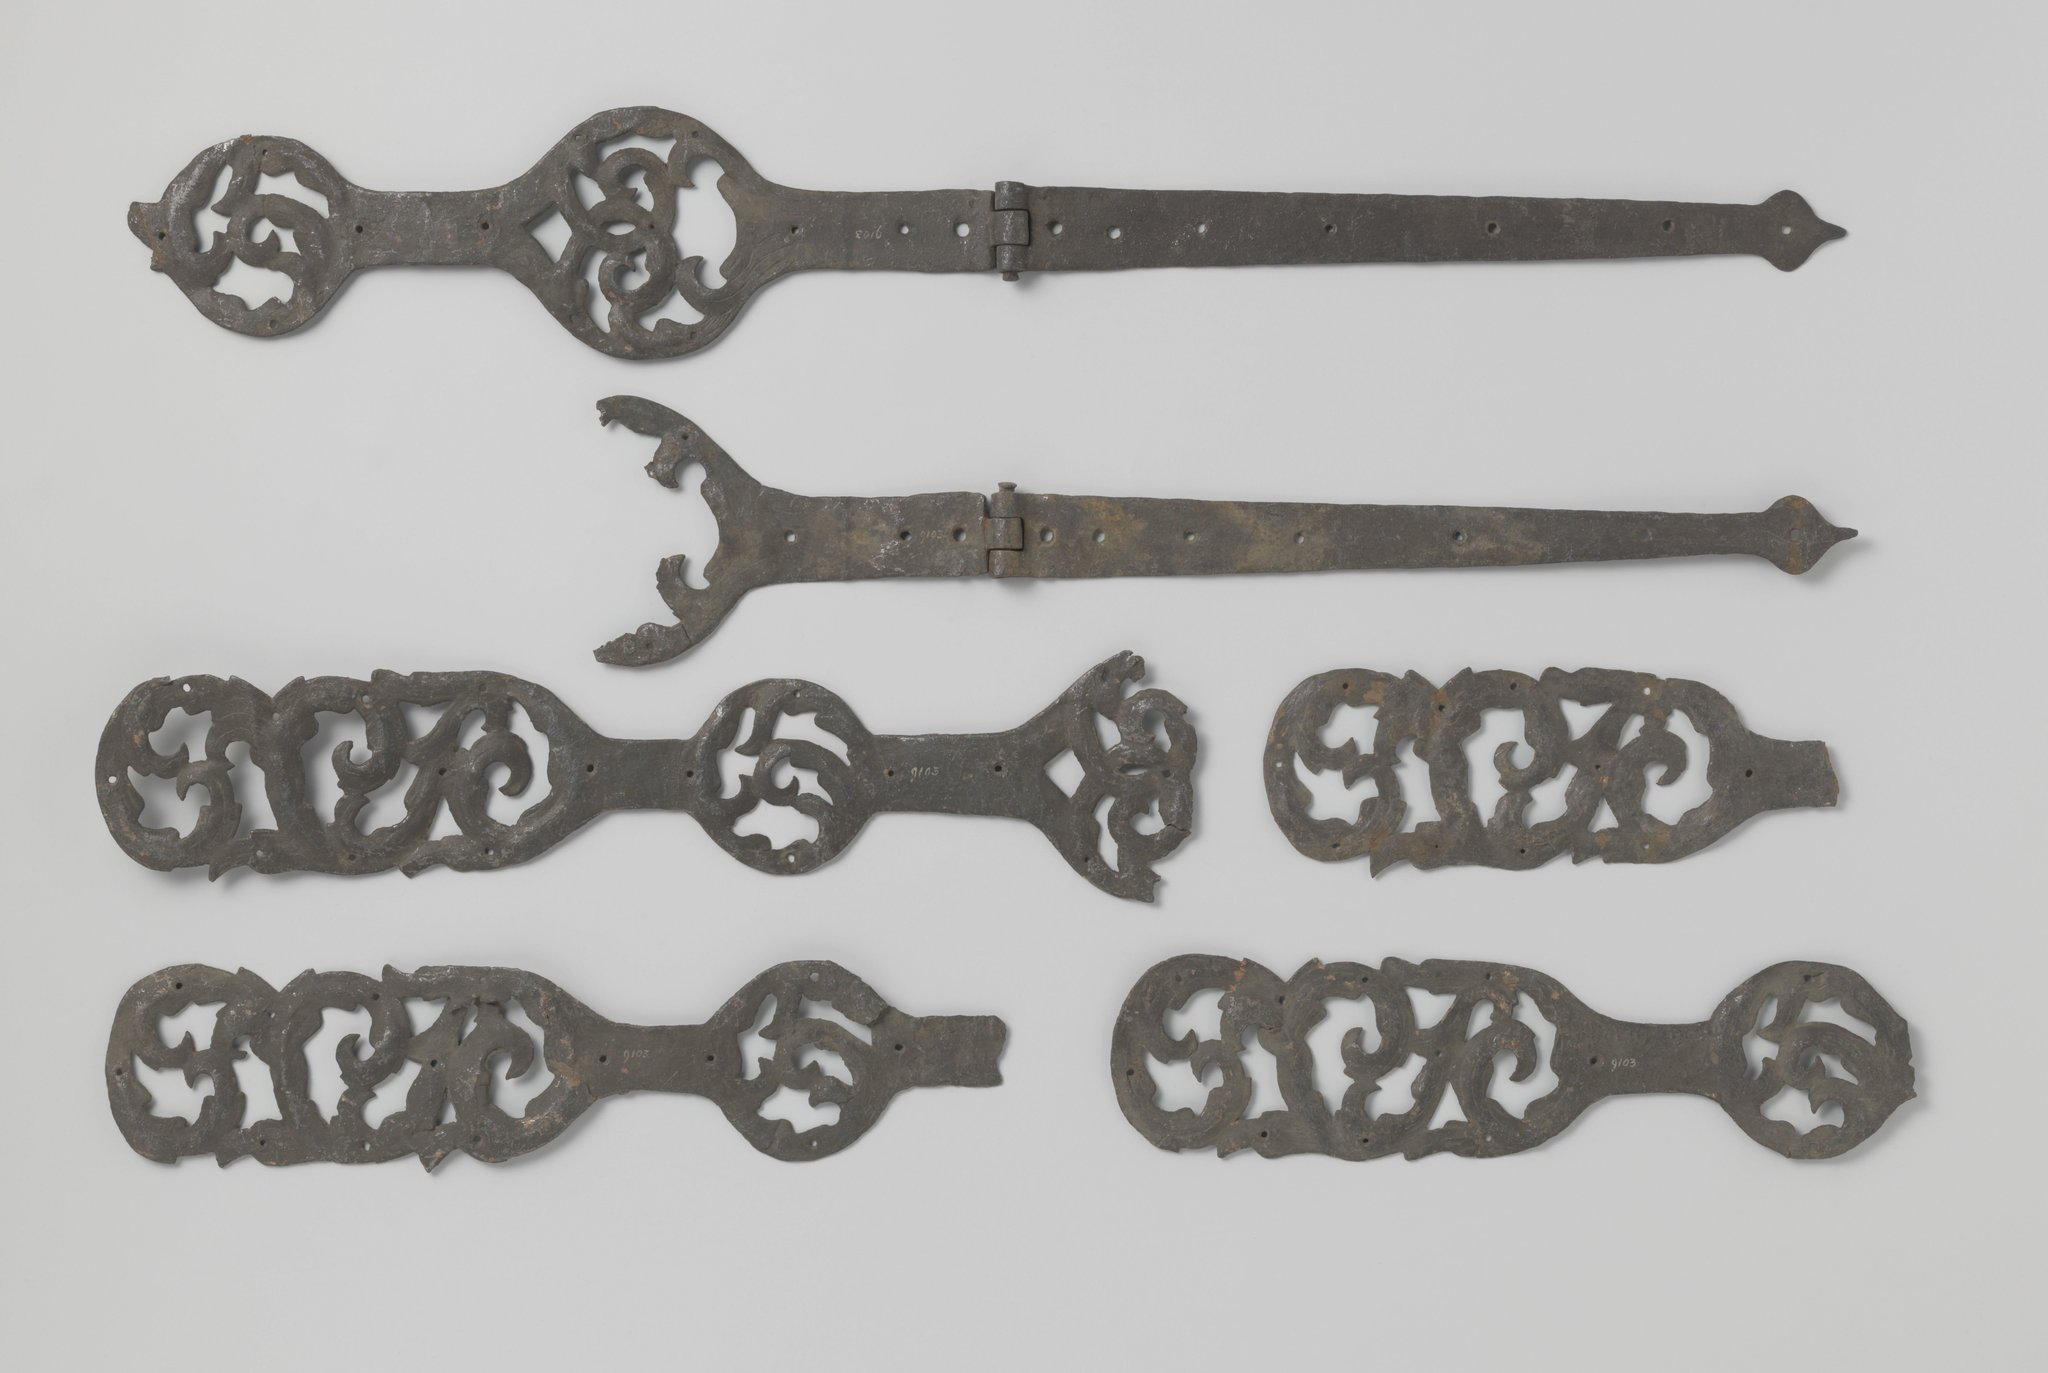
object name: hengsel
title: Zes delen van hengsels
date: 1400-1950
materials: iron